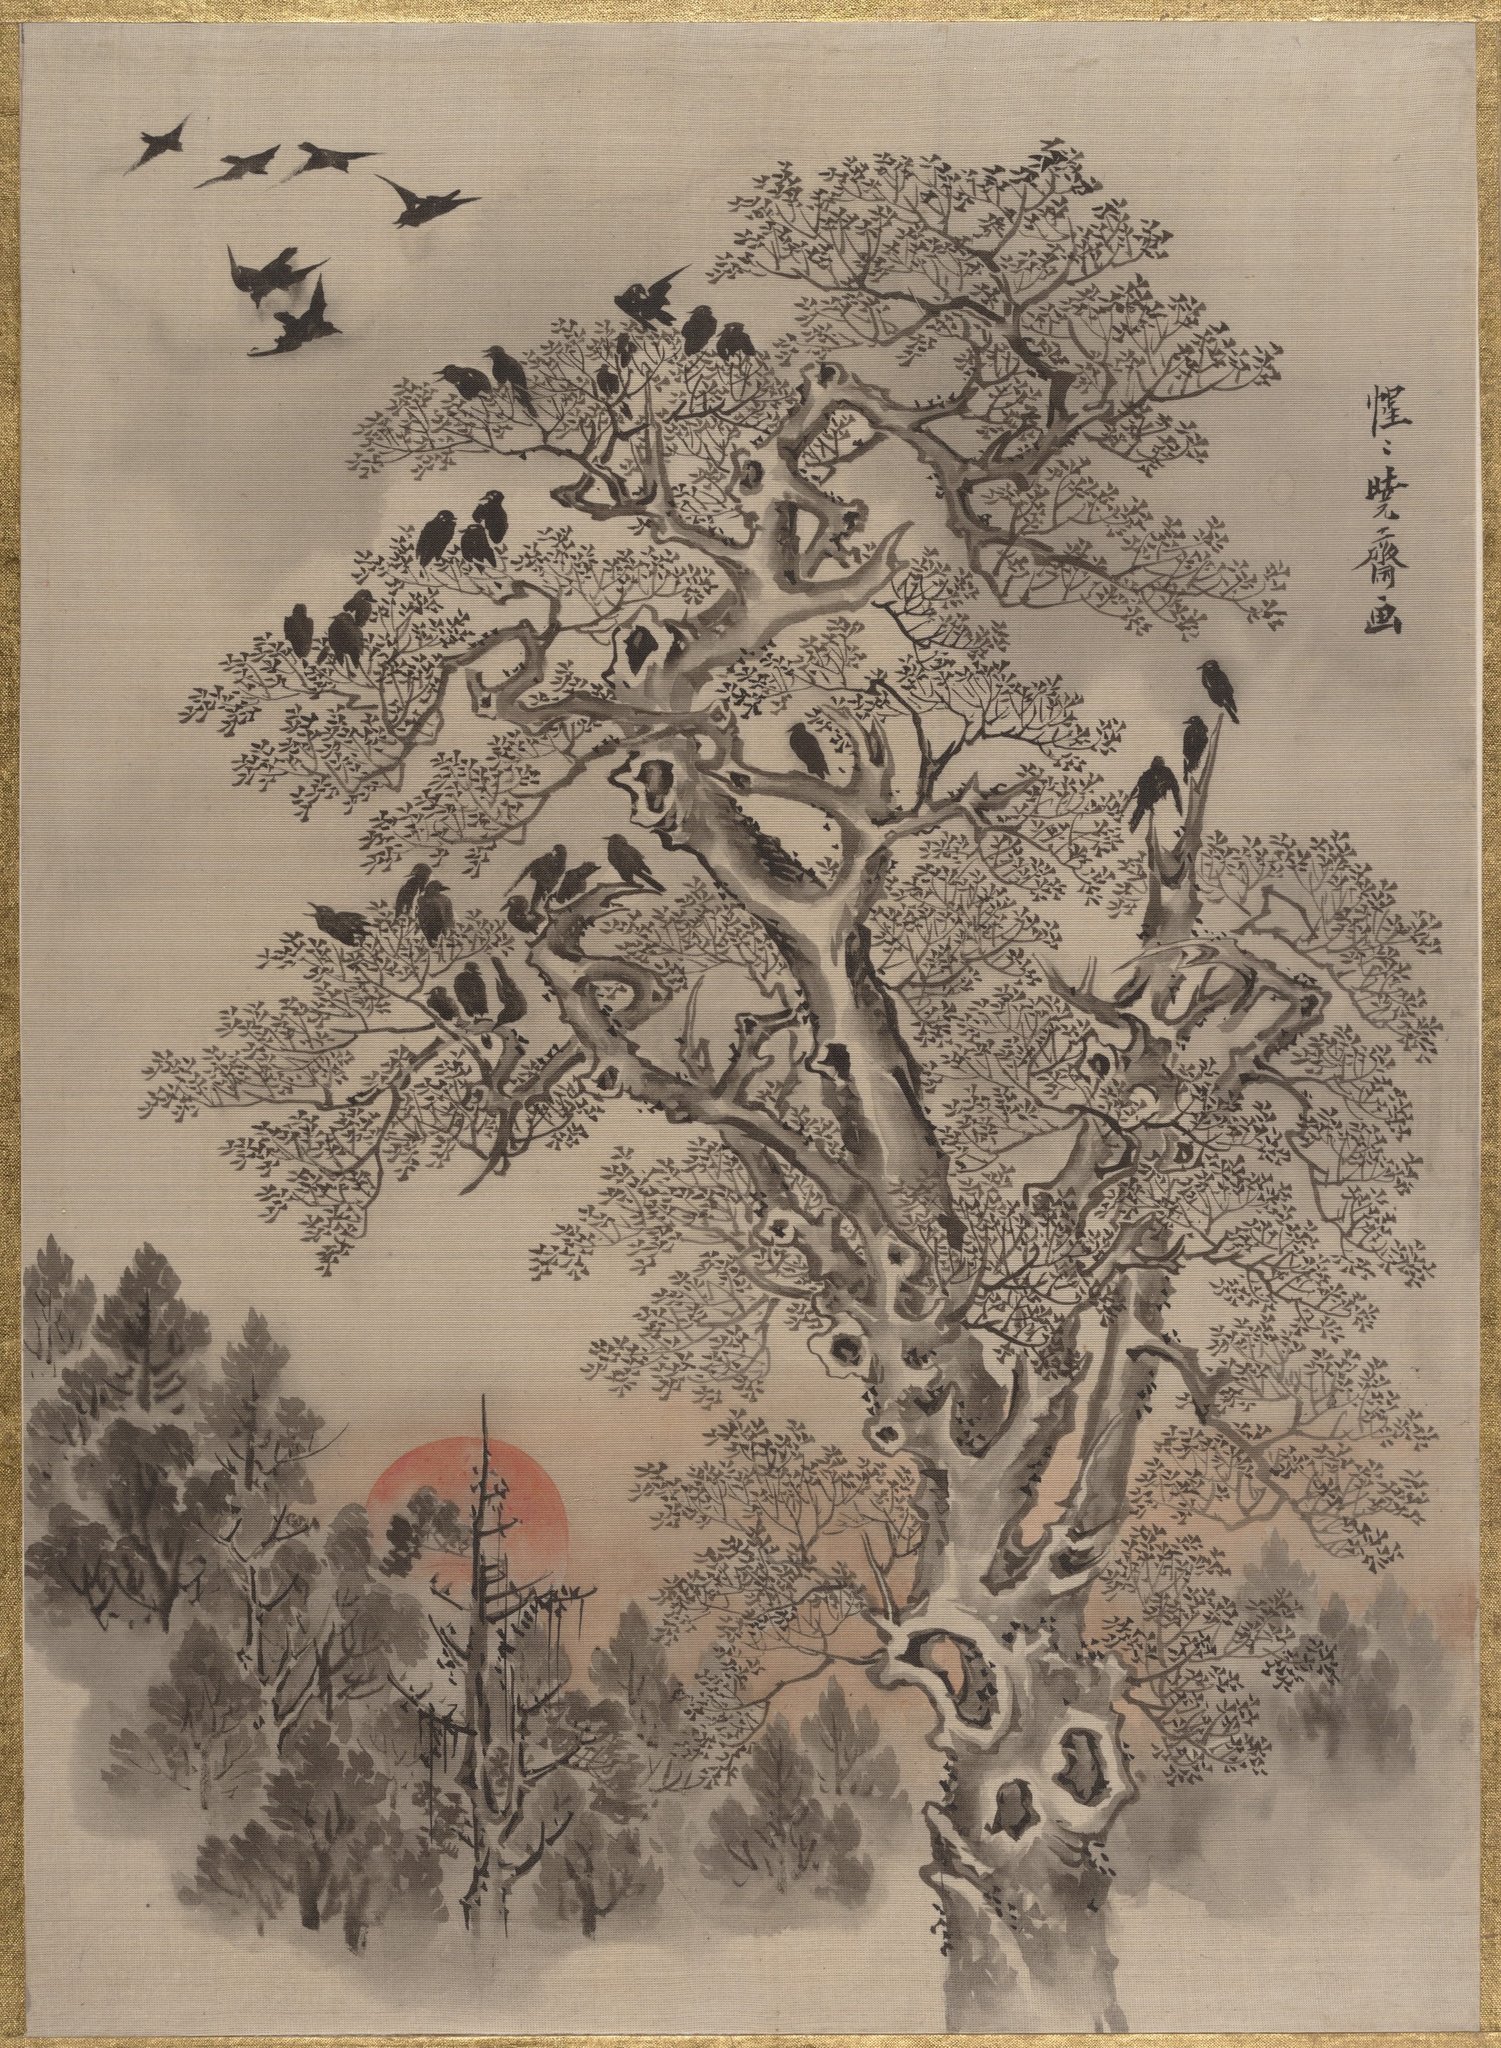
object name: album leaf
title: Flock of Crows at Dawn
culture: japanese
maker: kawanabe kyōsai 河鍋暁斎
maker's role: artist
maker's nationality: japanese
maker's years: 1831-1889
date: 1887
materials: ink, silk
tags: birds,sun,trees